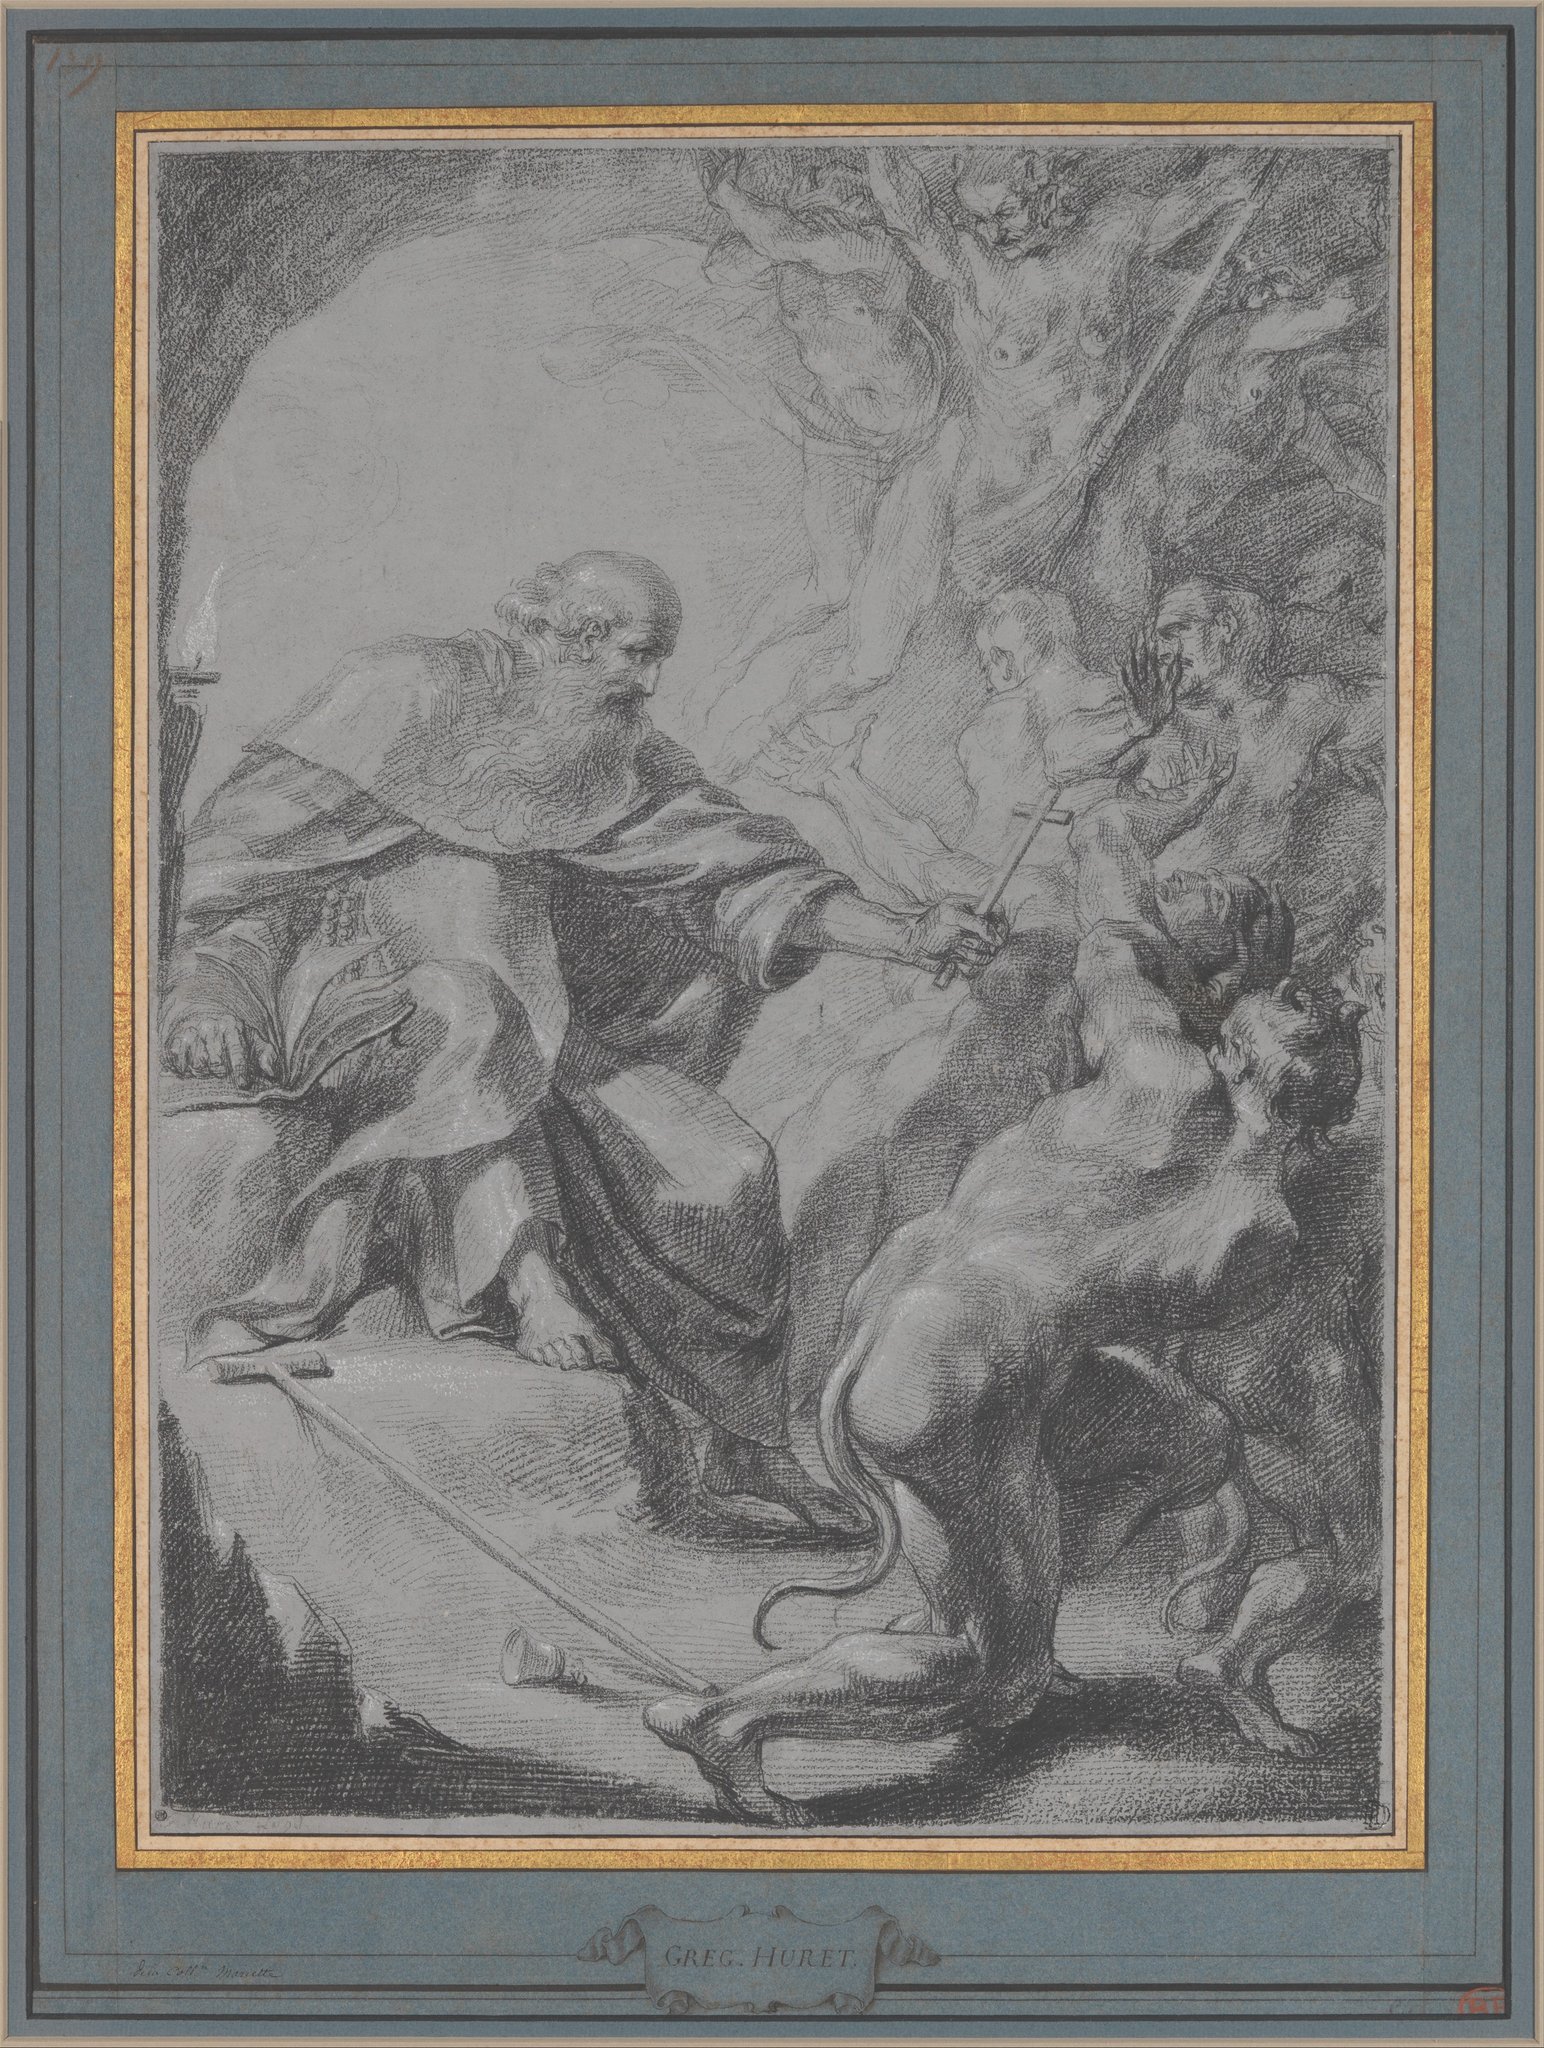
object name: drawing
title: St. Anthony of Egypt Driving Away Devils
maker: grégoire huret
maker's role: artist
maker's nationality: french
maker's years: 1606-1670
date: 1601-1700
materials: chalk, paper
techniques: heightening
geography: france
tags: saint anthony,devil